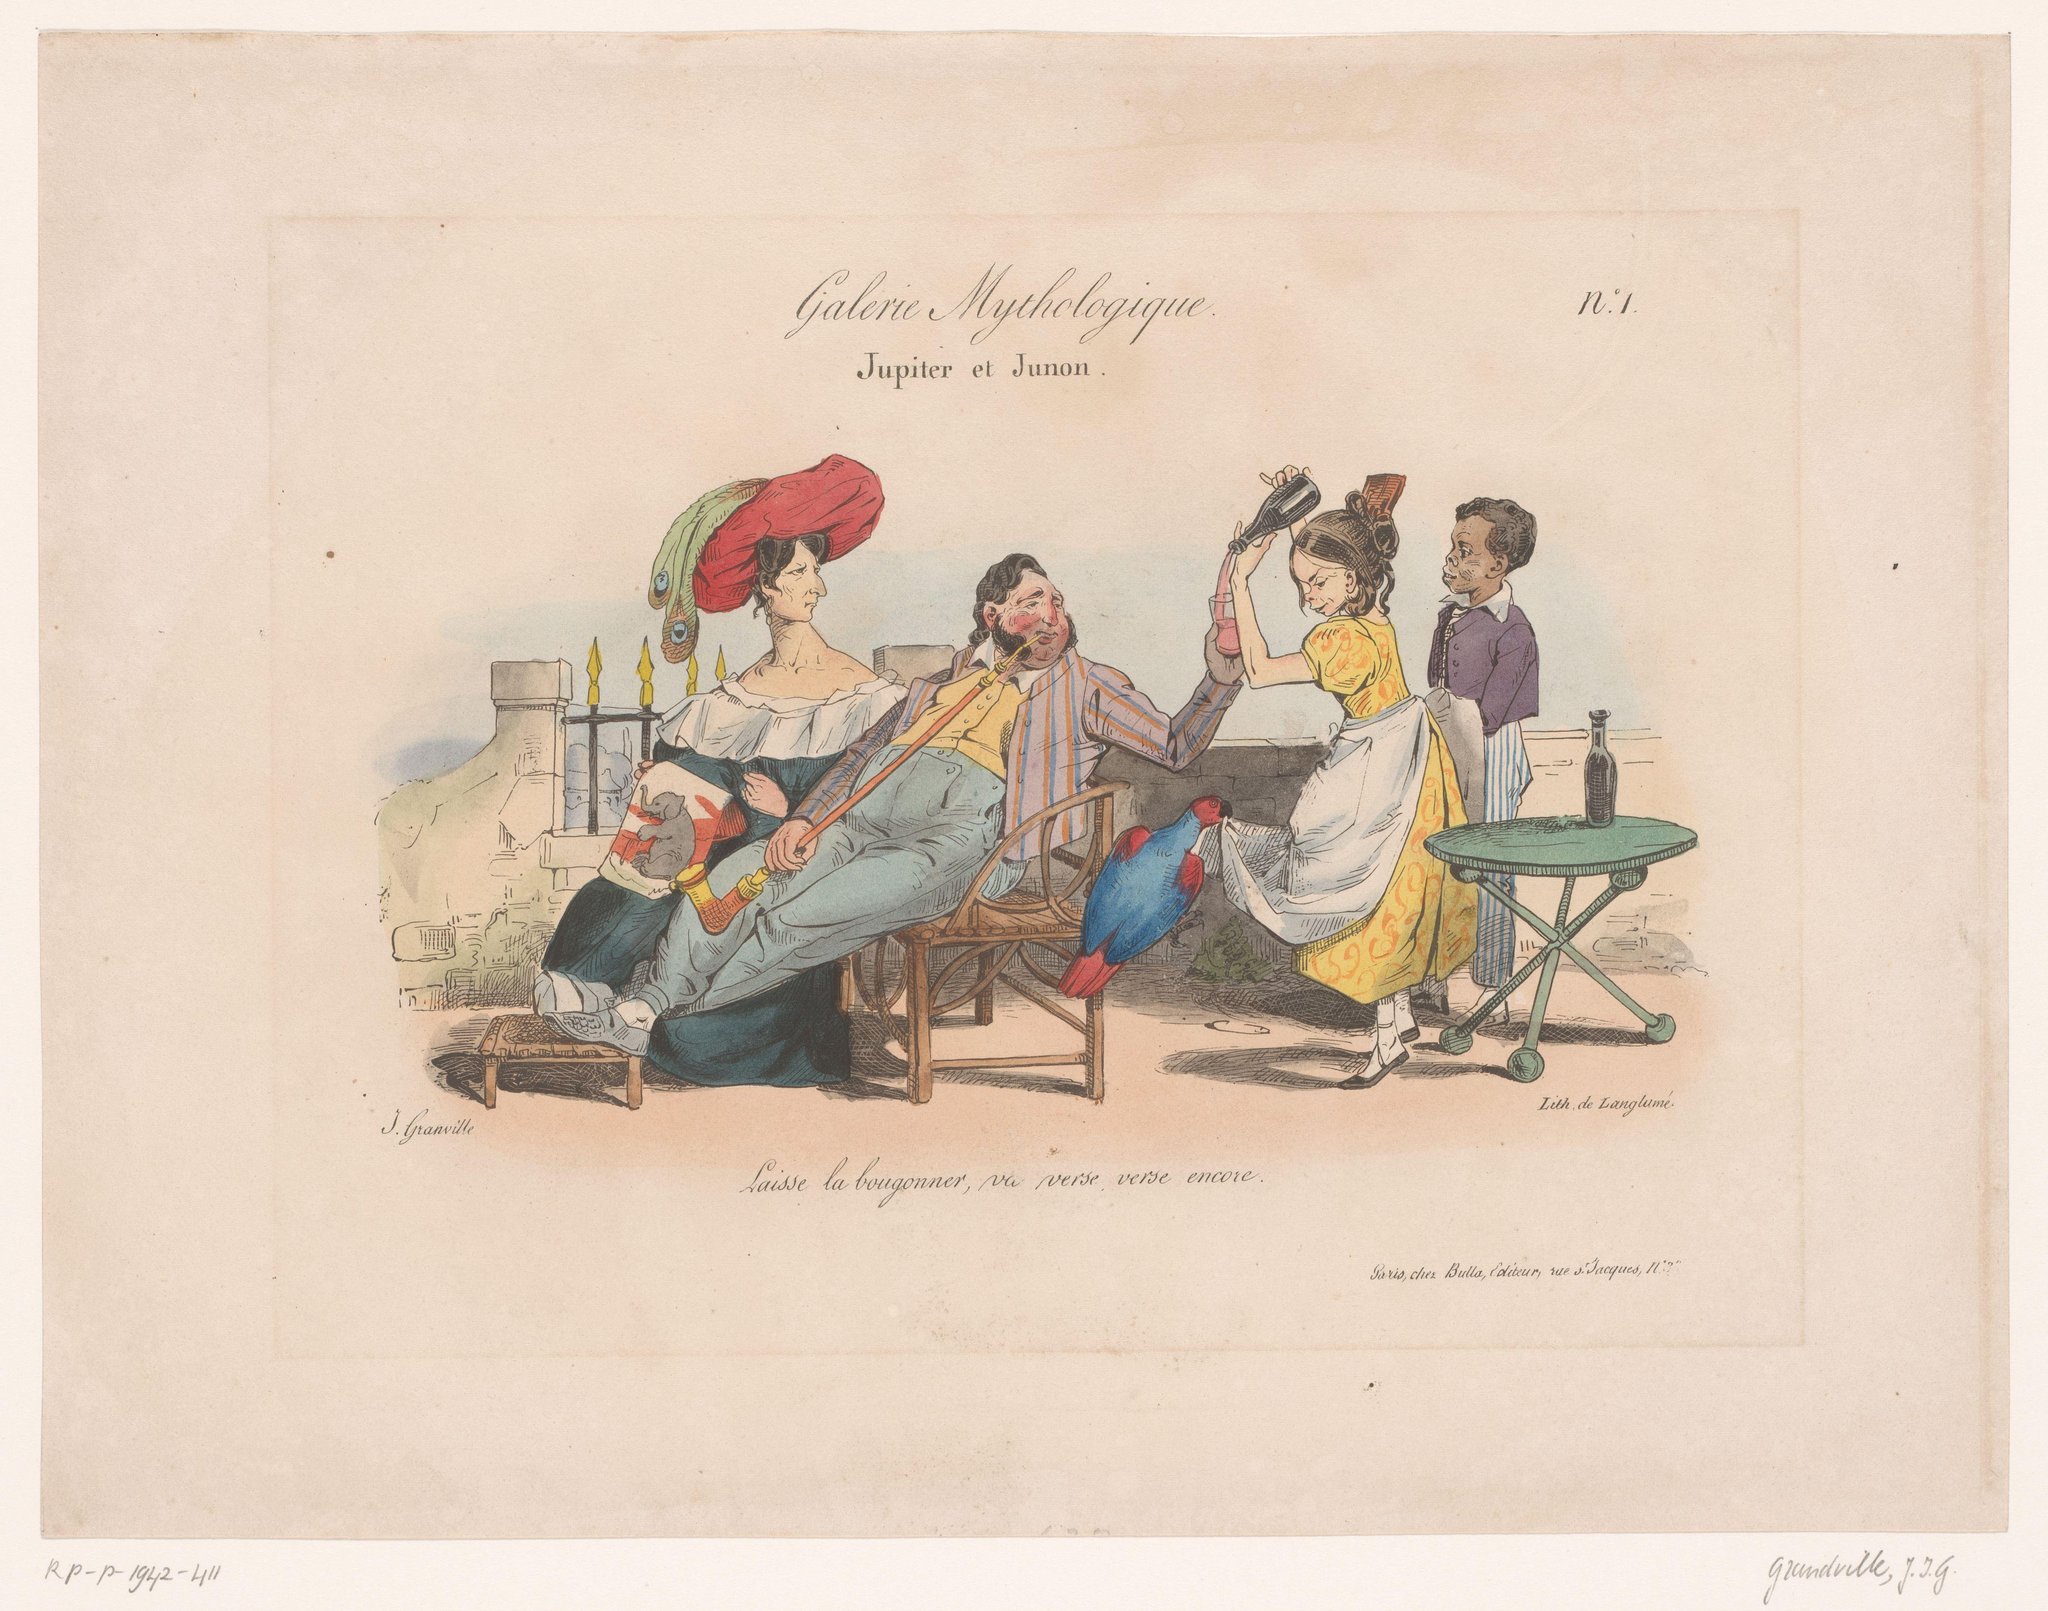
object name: cartoon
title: Galerie Mythologique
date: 1830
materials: paper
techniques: hand coloring, lithograph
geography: paris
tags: water-pipe, hookah, narghile, (story of) juno (hera), (story of) jupiter (zeus), ornamental birds: parrot, hebe as cup-bearer of the gods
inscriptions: collector's mark: Lugt 2228a, collector's mark: Lugt 2760